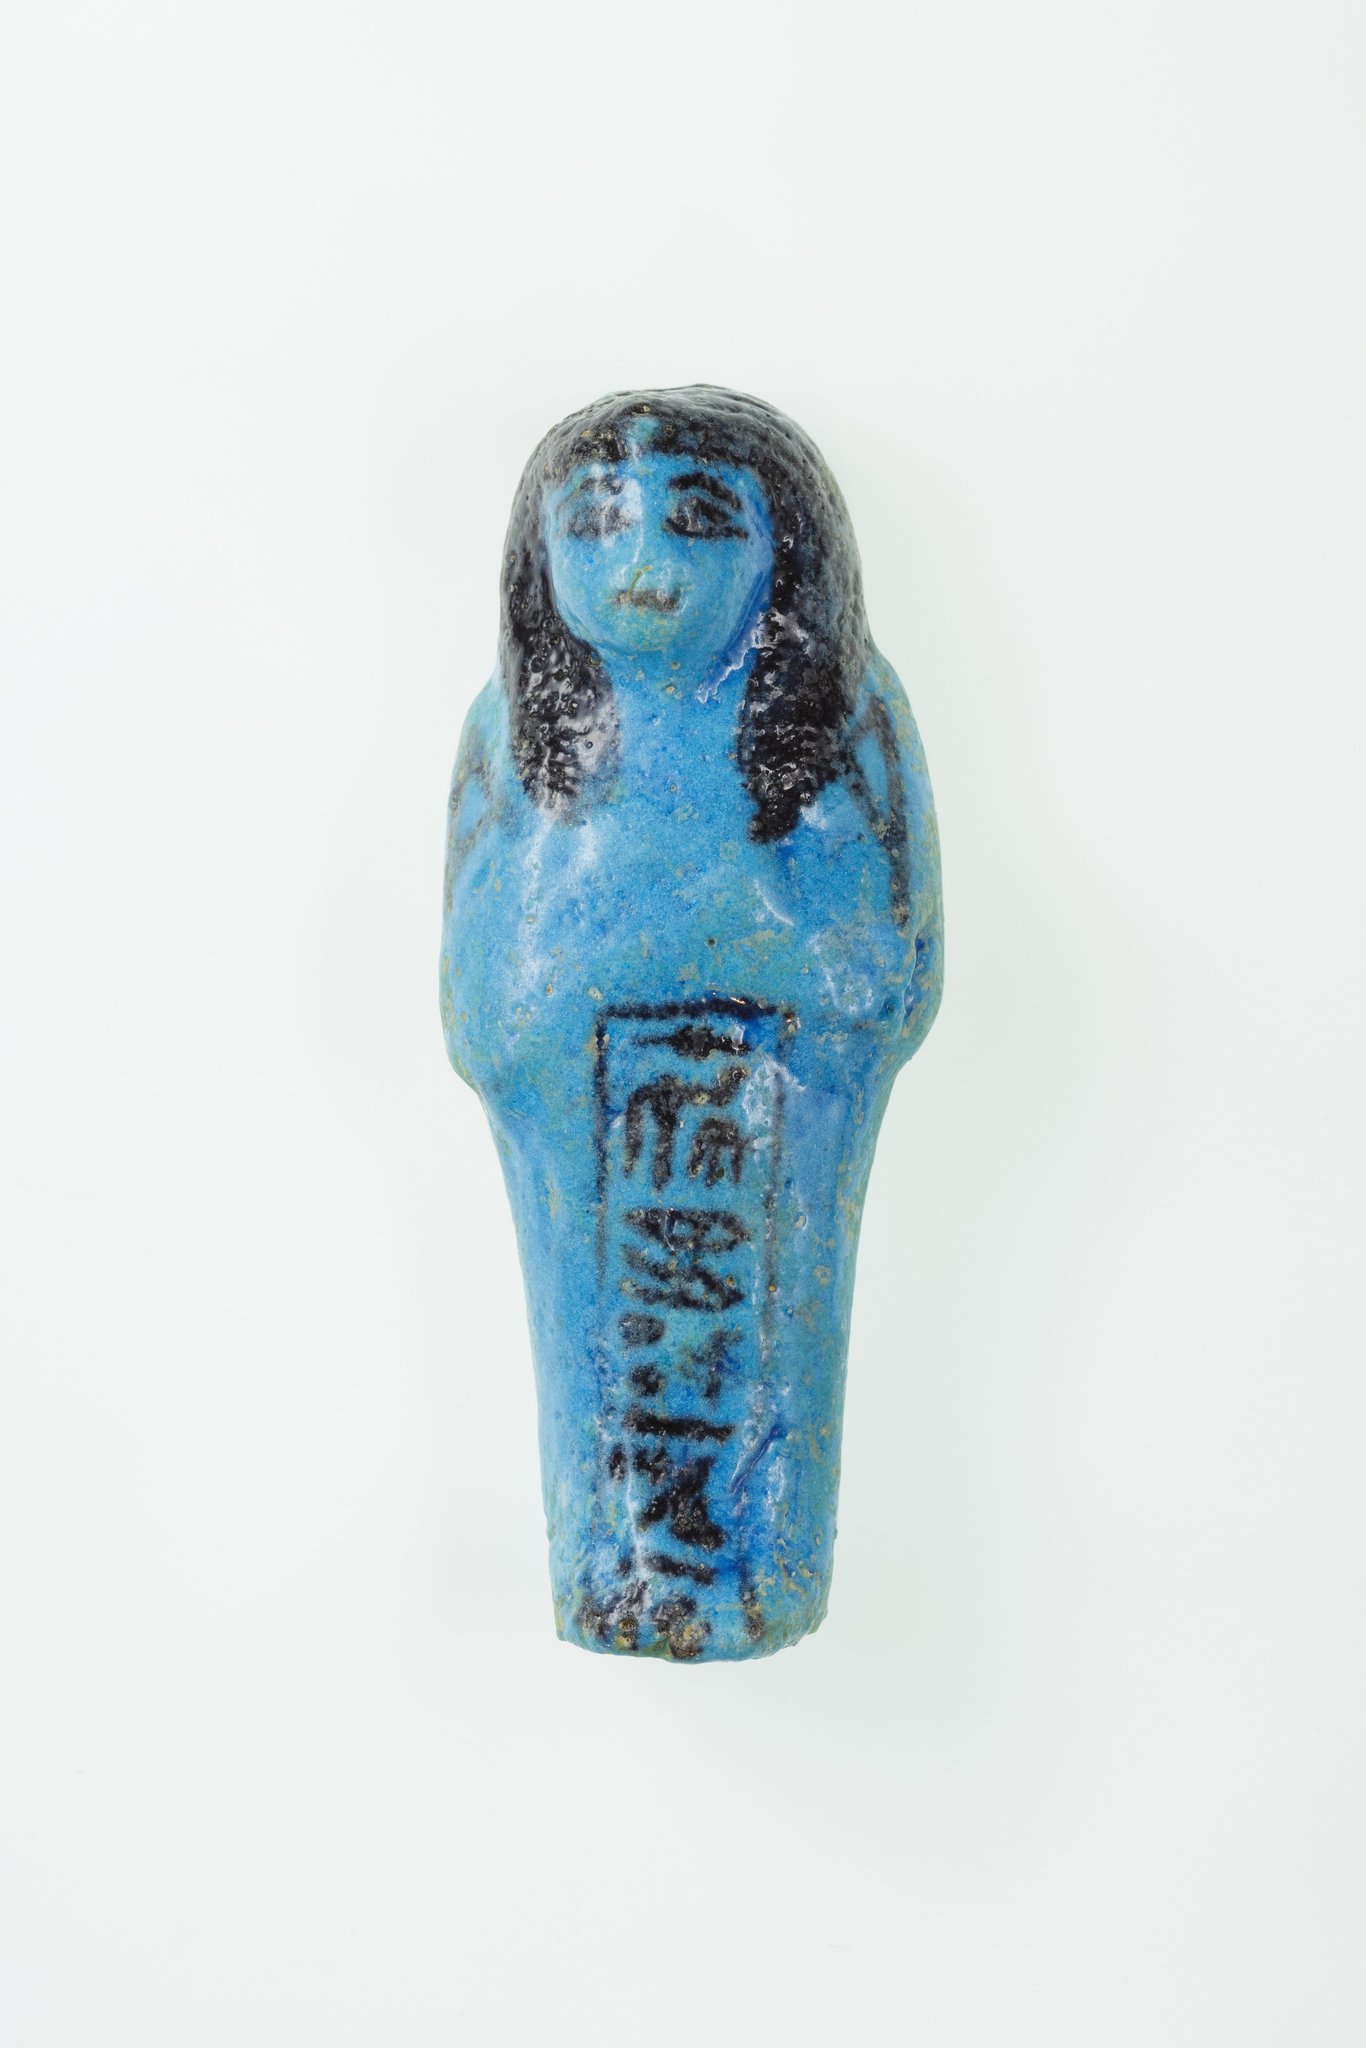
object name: shabti, worker, nauny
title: Worker Shabti of Nauny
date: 1050 BCE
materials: faience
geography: egypt